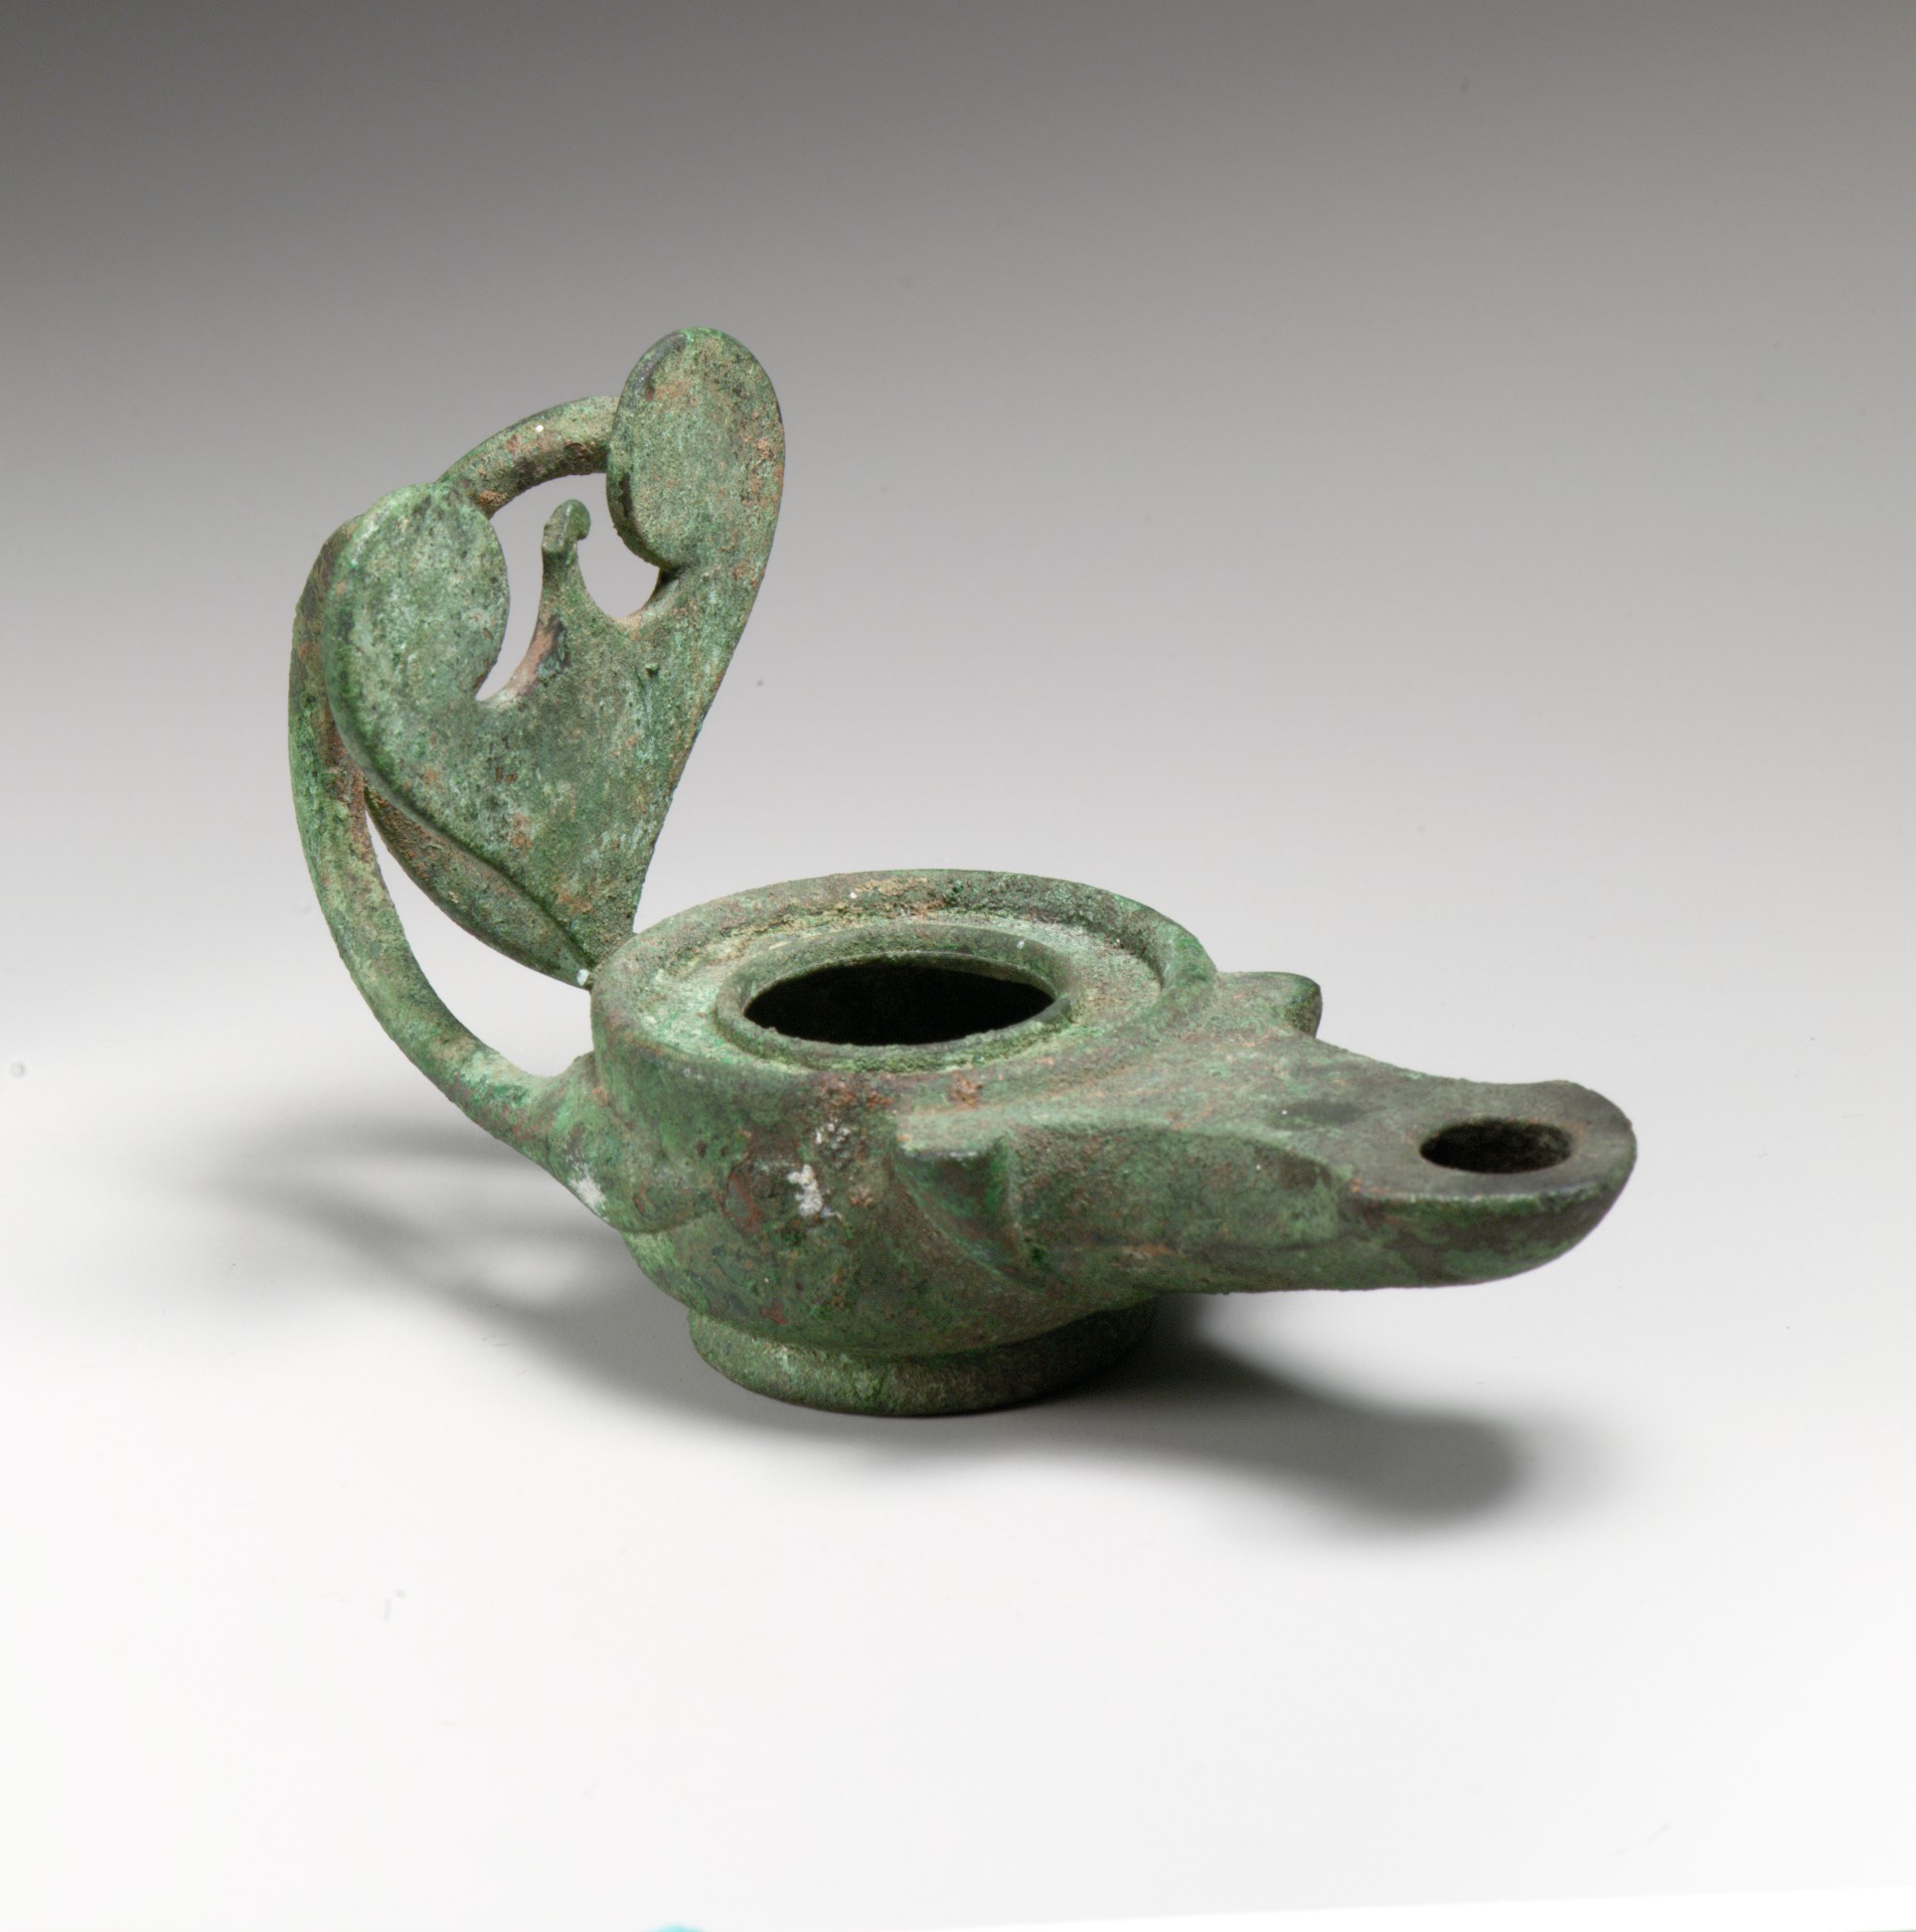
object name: lamp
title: Bronze lamp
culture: roman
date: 67-100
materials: bronze